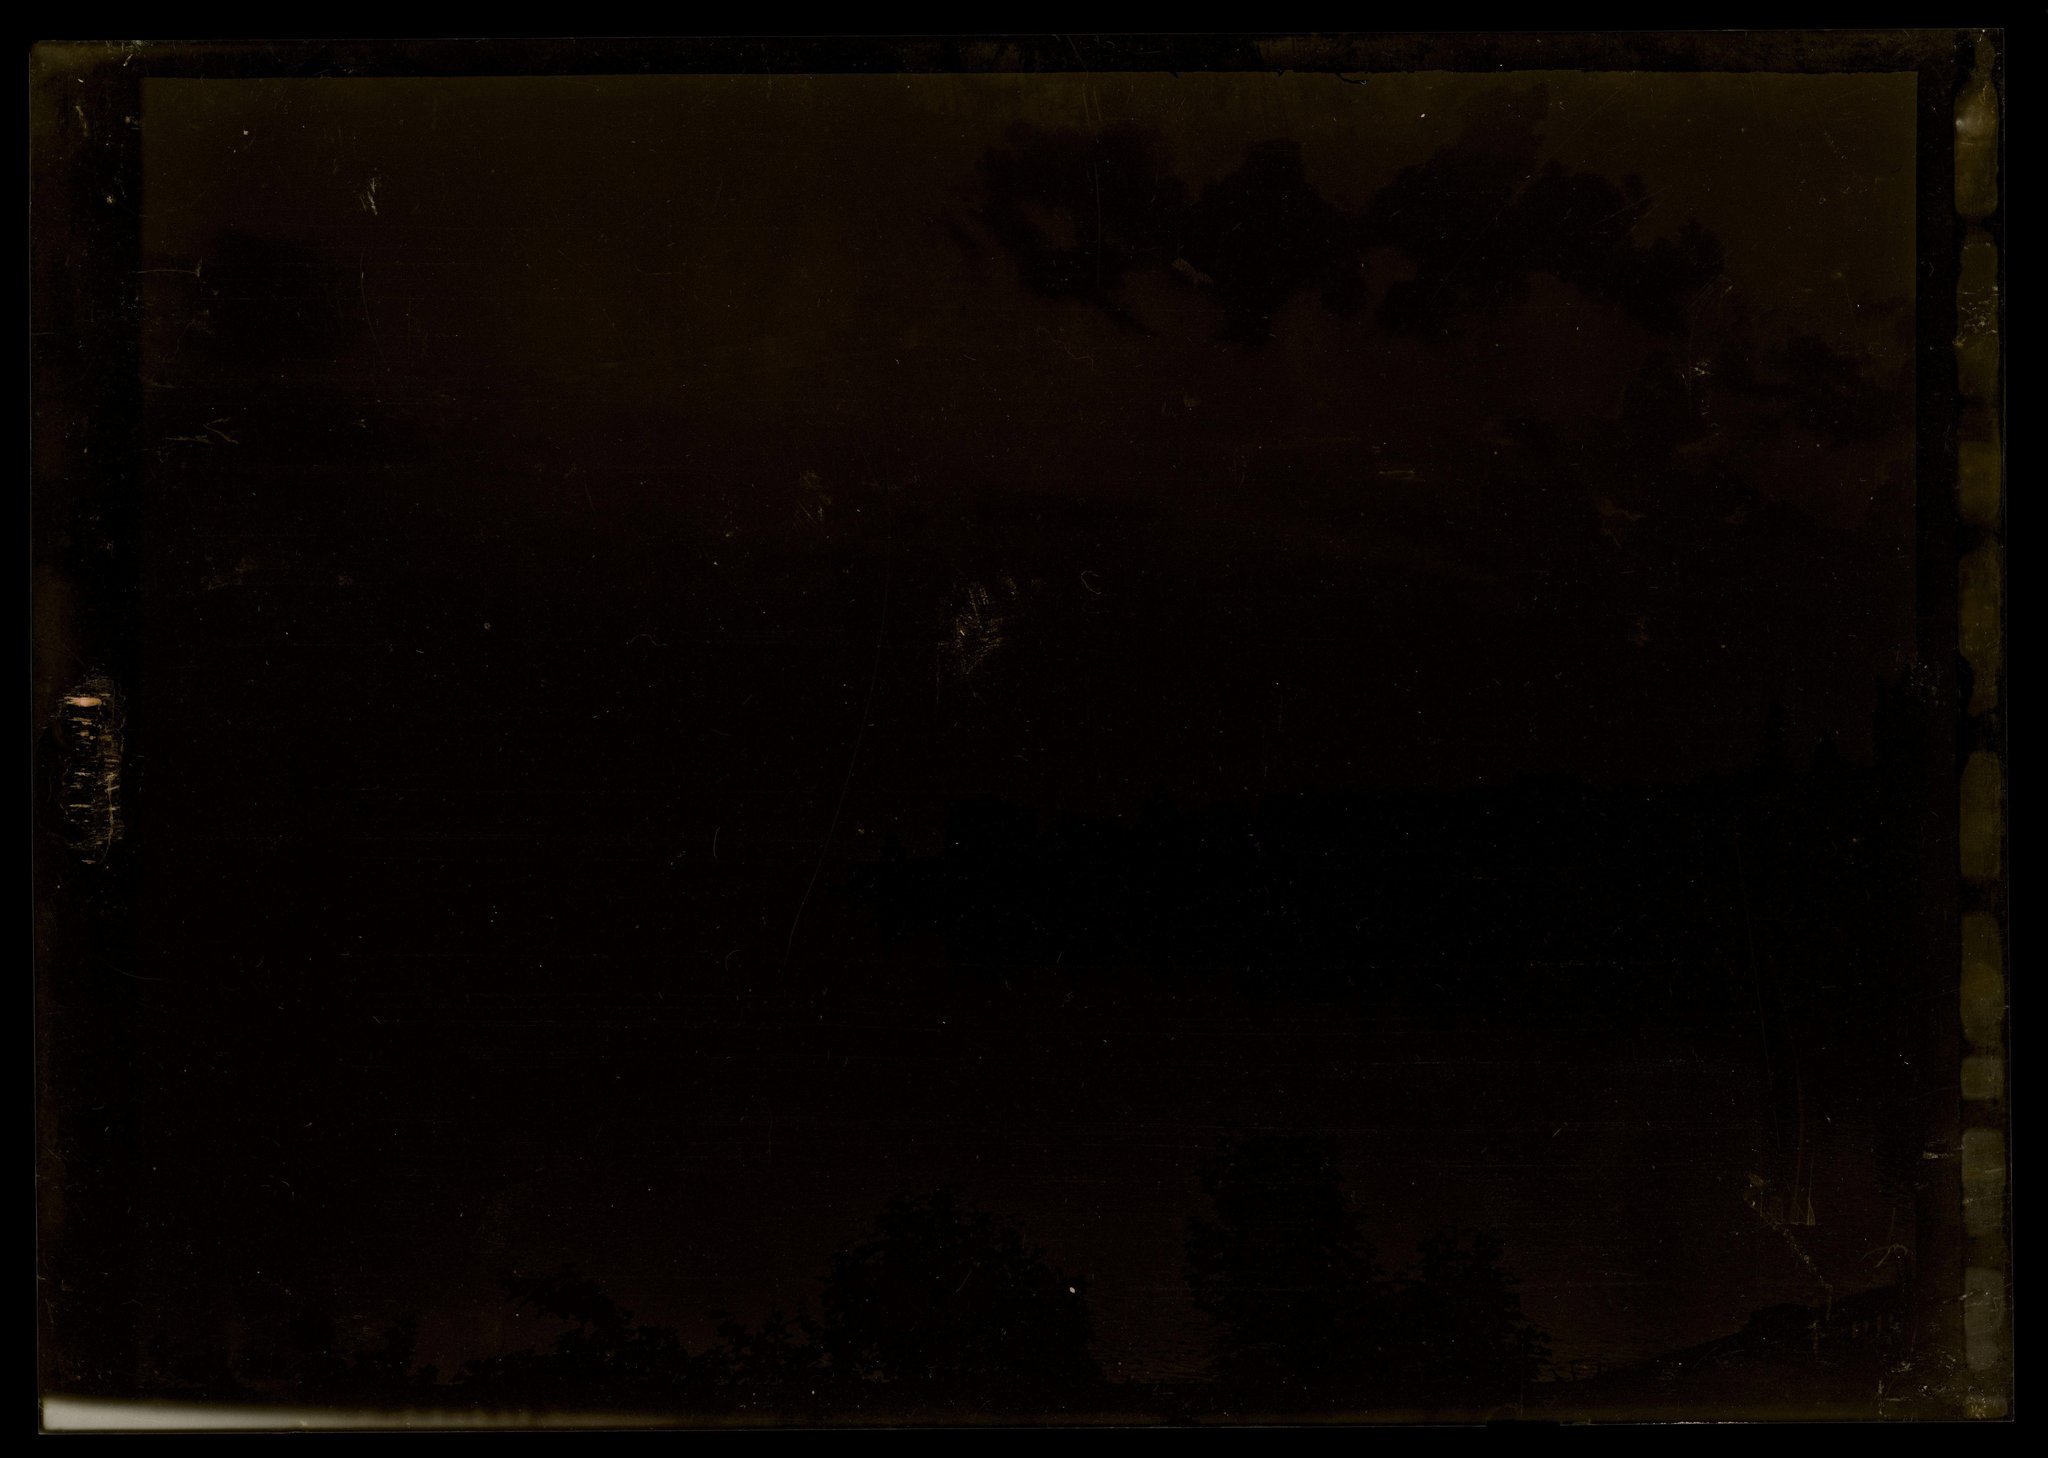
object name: photograph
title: Filmnegatief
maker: Anonymous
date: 1907-1935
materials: film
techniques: gelatin silver negative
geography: europe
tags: europe